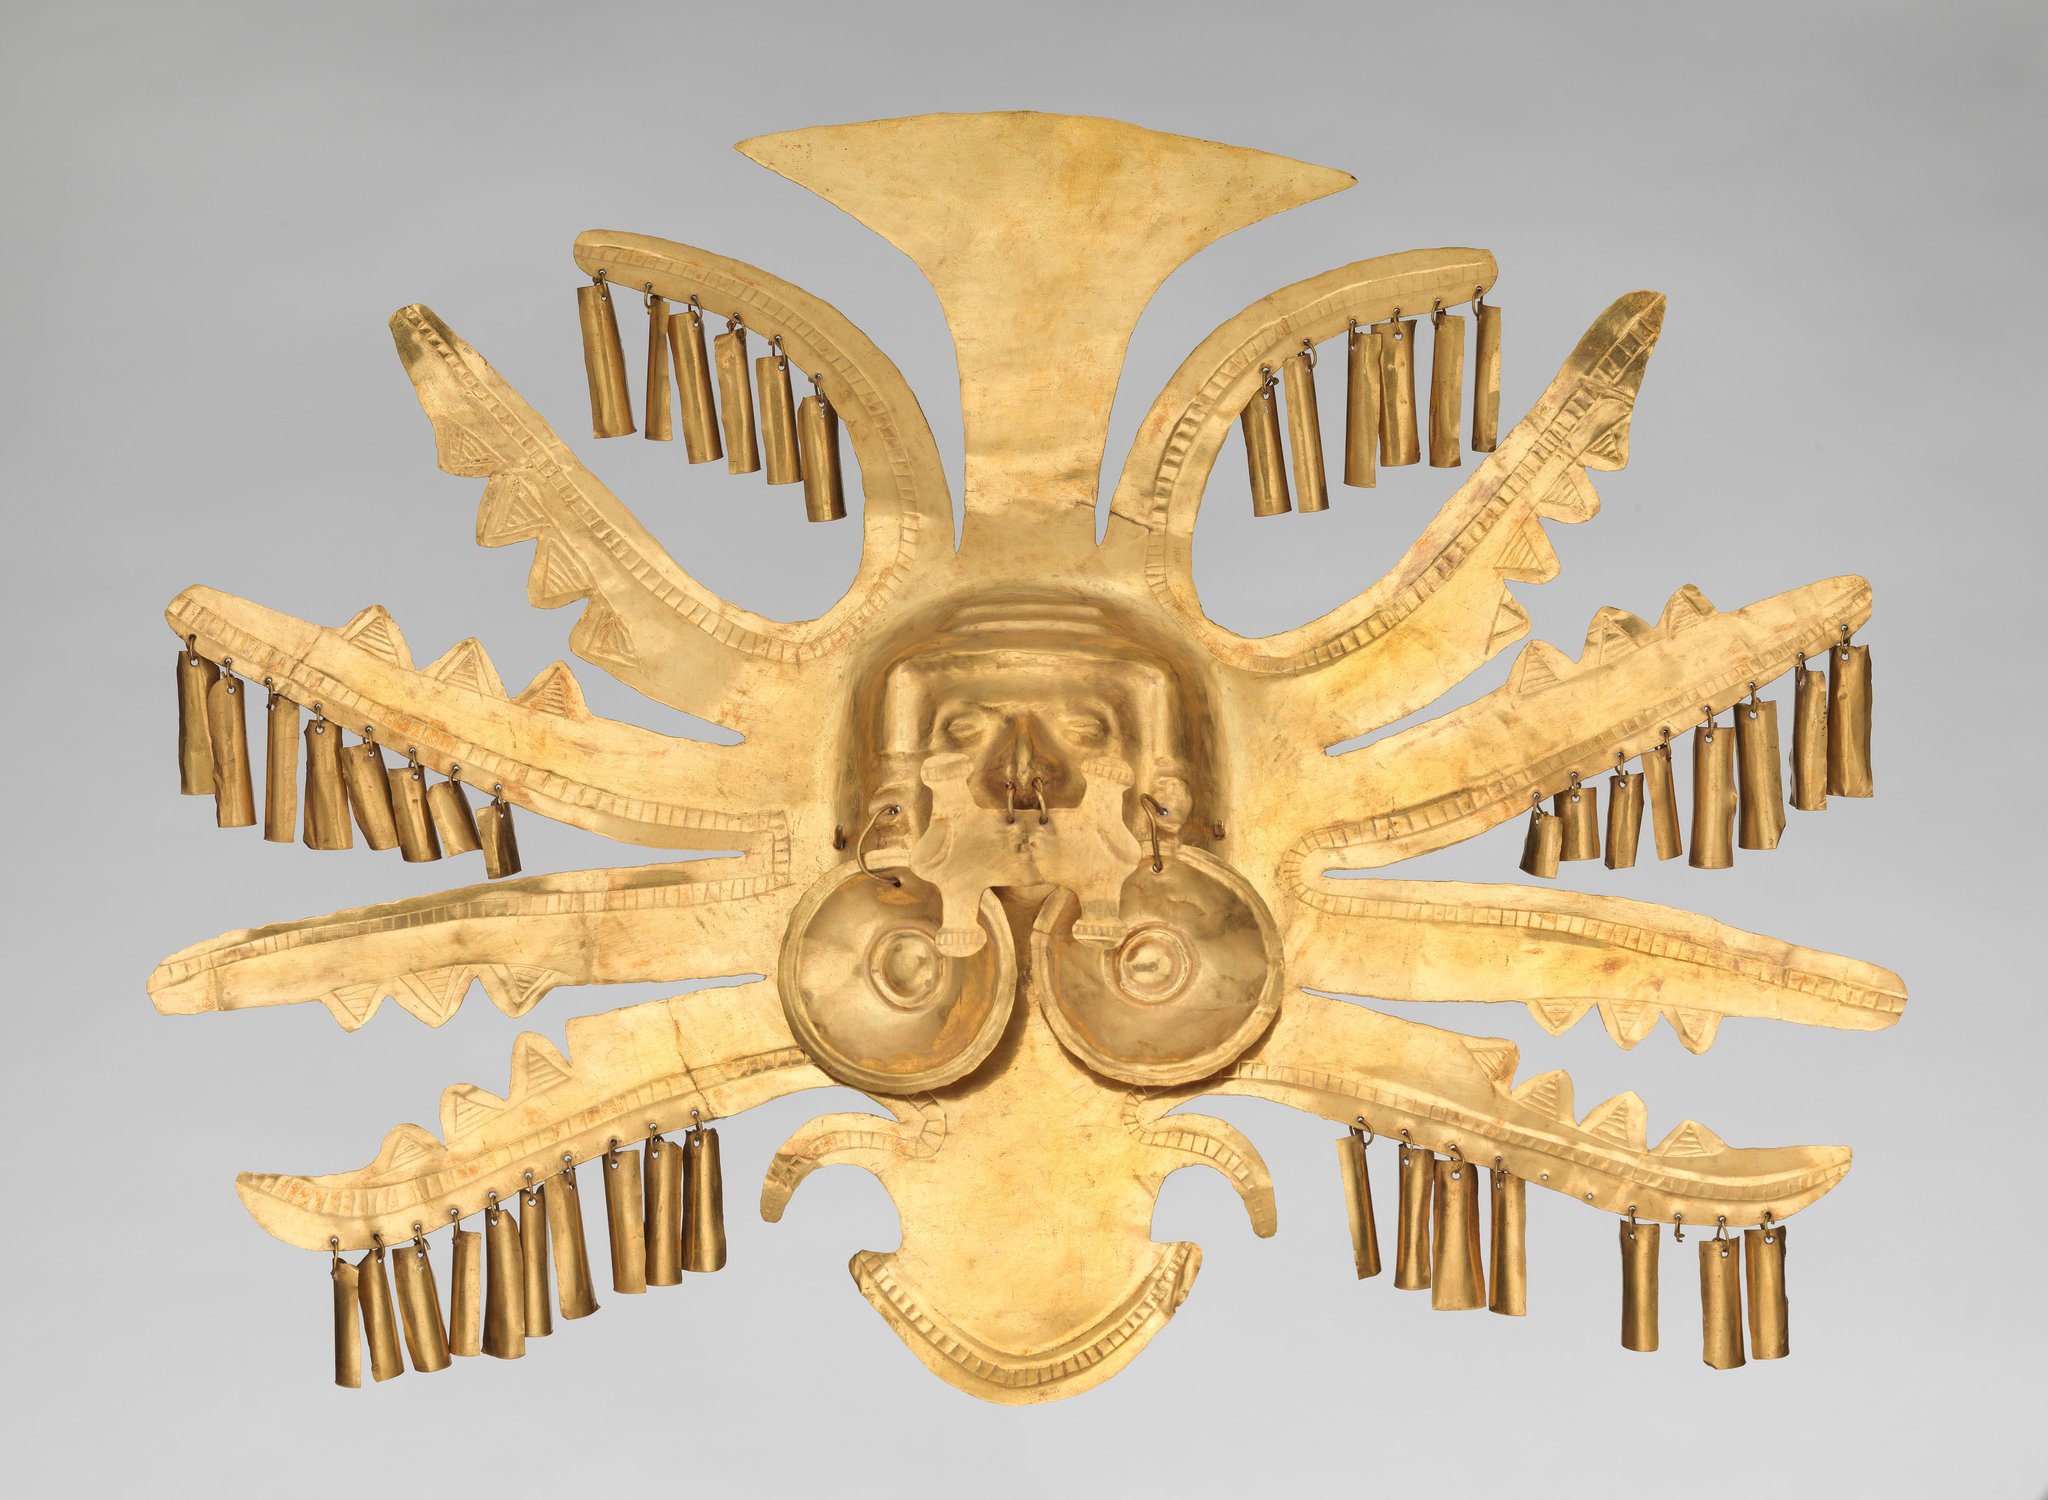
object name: headdress ornament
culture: calima or yotoco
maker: calima (yotoco) artist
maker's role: artist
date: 100 BCE-700 CE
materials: gold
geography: colombia